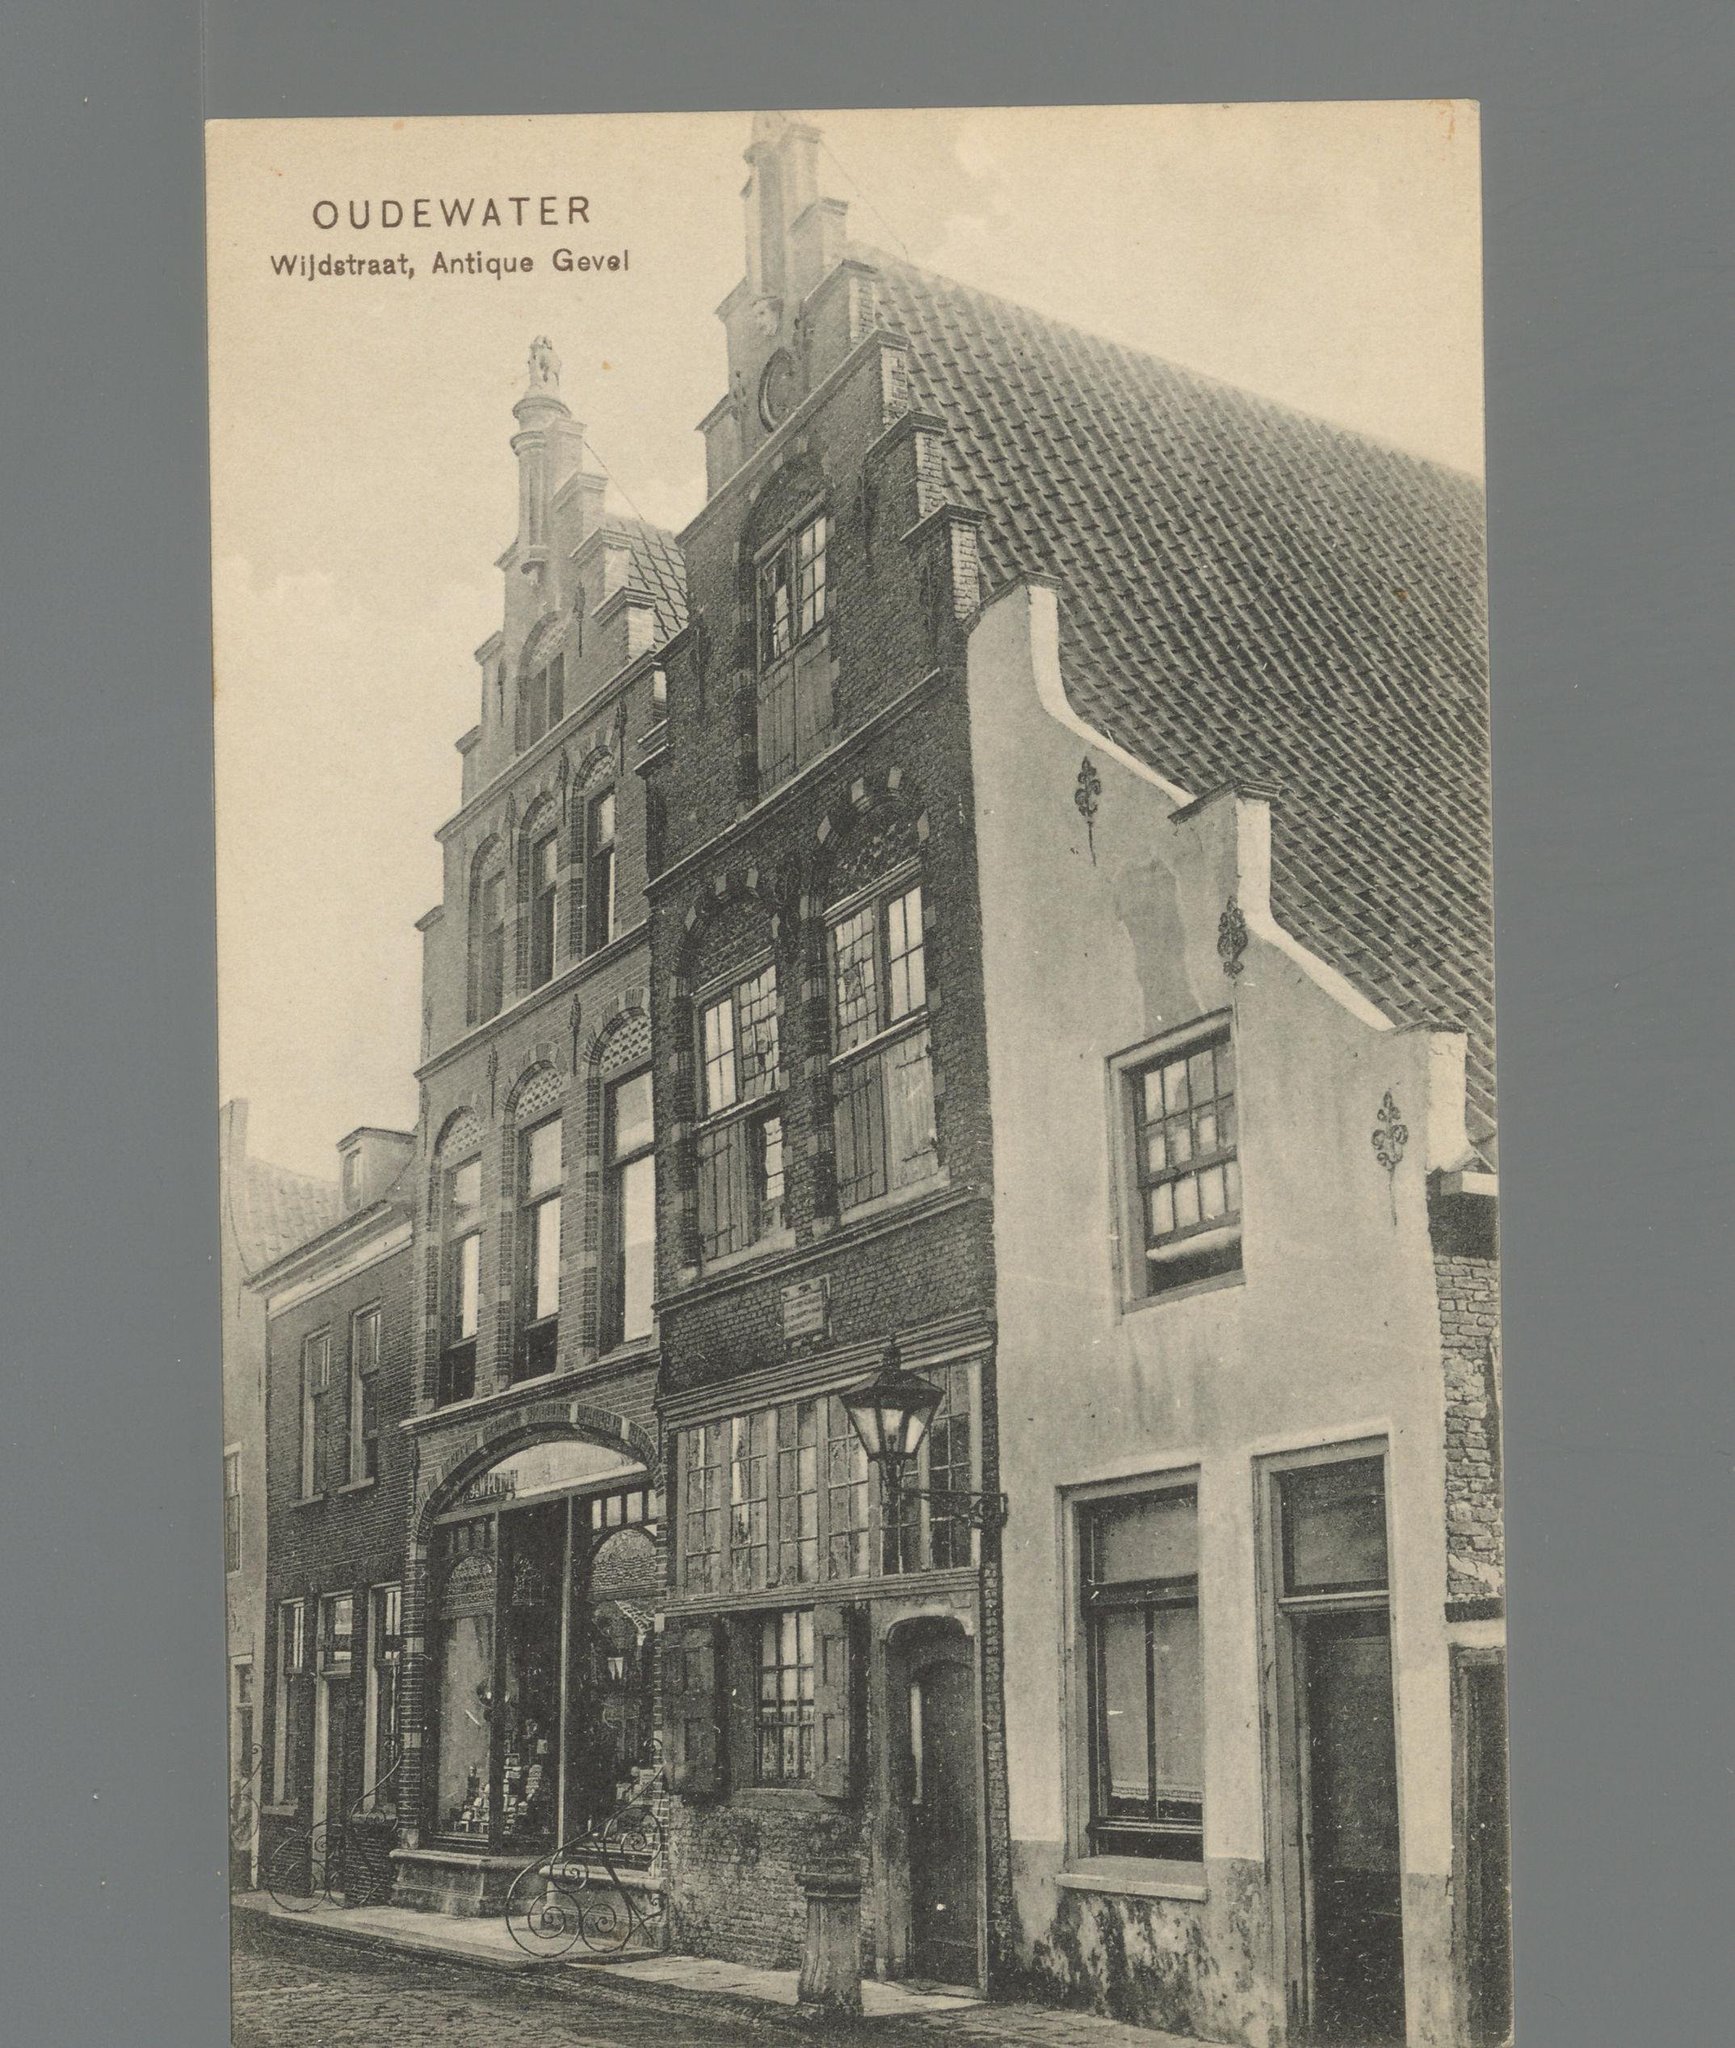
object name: ansichtkaart, prentbriefkaart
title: Oudewater. Wijdstraat, antique gevel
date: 1905-1930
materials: cardboard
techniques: photograph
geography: oudewater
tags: façade (of house or building), street